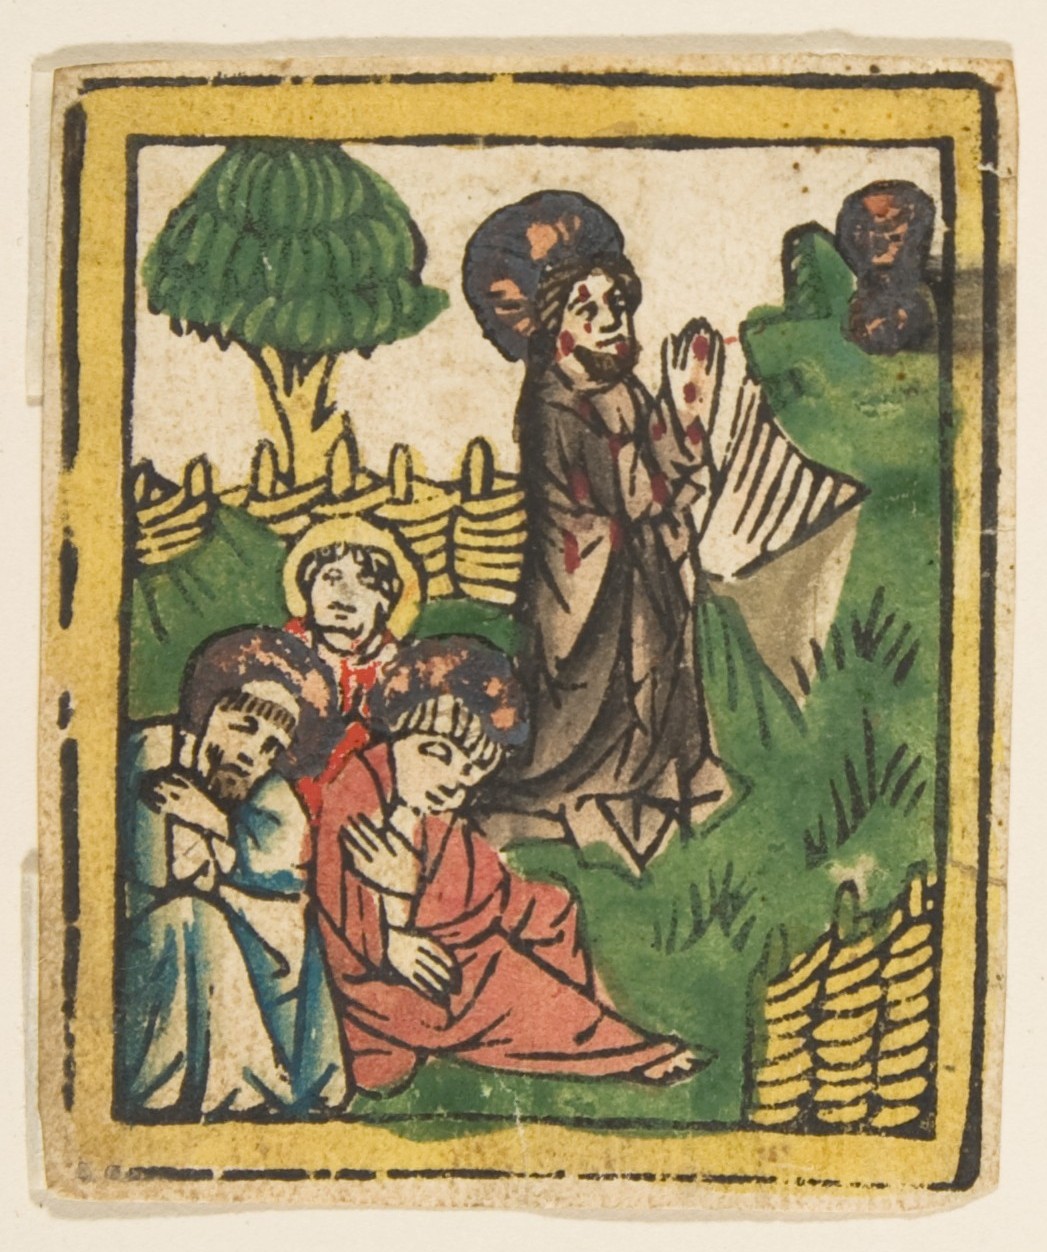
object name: print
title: Christ on the Mount of Olives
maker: anonymous, german, 15th century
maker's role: artist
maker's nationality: german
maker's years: 1400-1500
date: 1401-1500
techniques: hand coloring, woodcut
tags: men,trees,christ